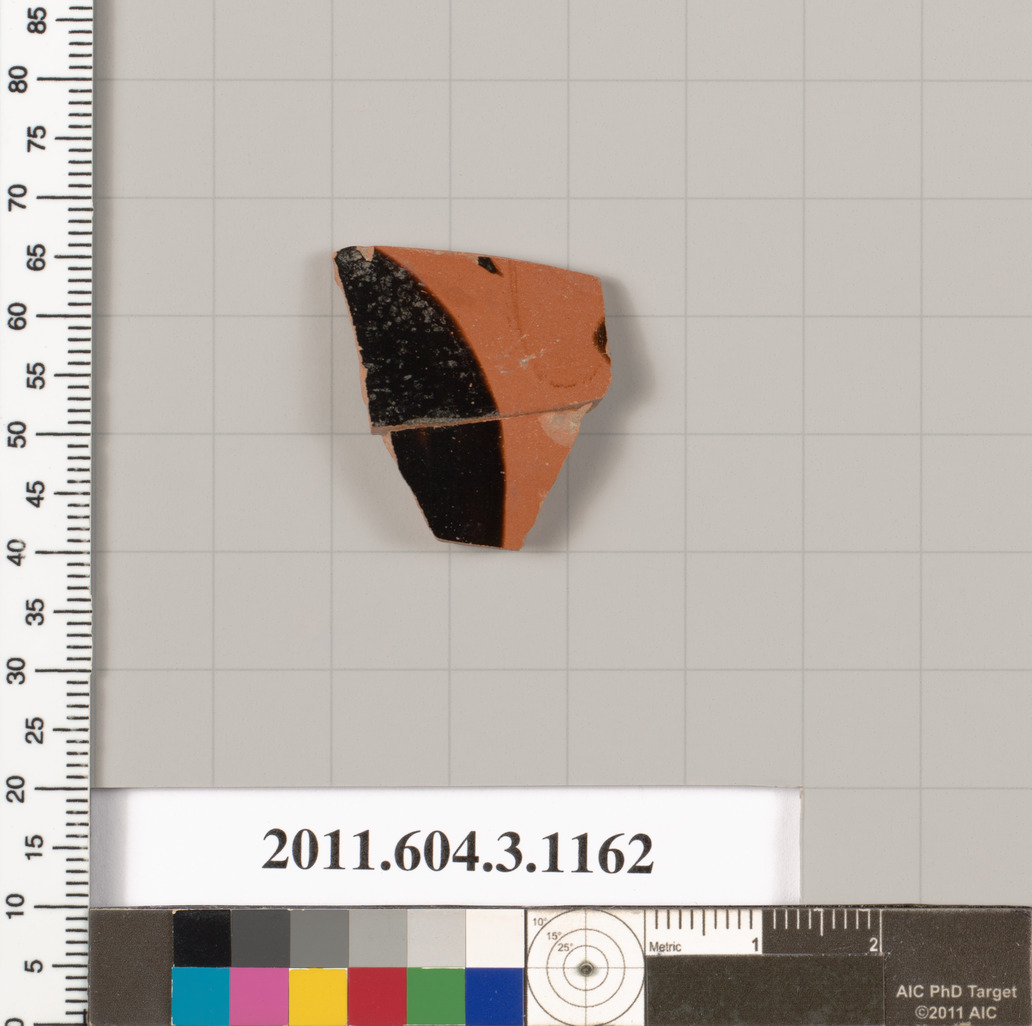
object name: mastoid or kyathos fragment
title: Terracotta fragment of a mastoid (drinking cup with narrow base) or a kyathos (cup-shaped ladle)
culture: greek, attic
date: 534-468 BCE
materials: terracotta